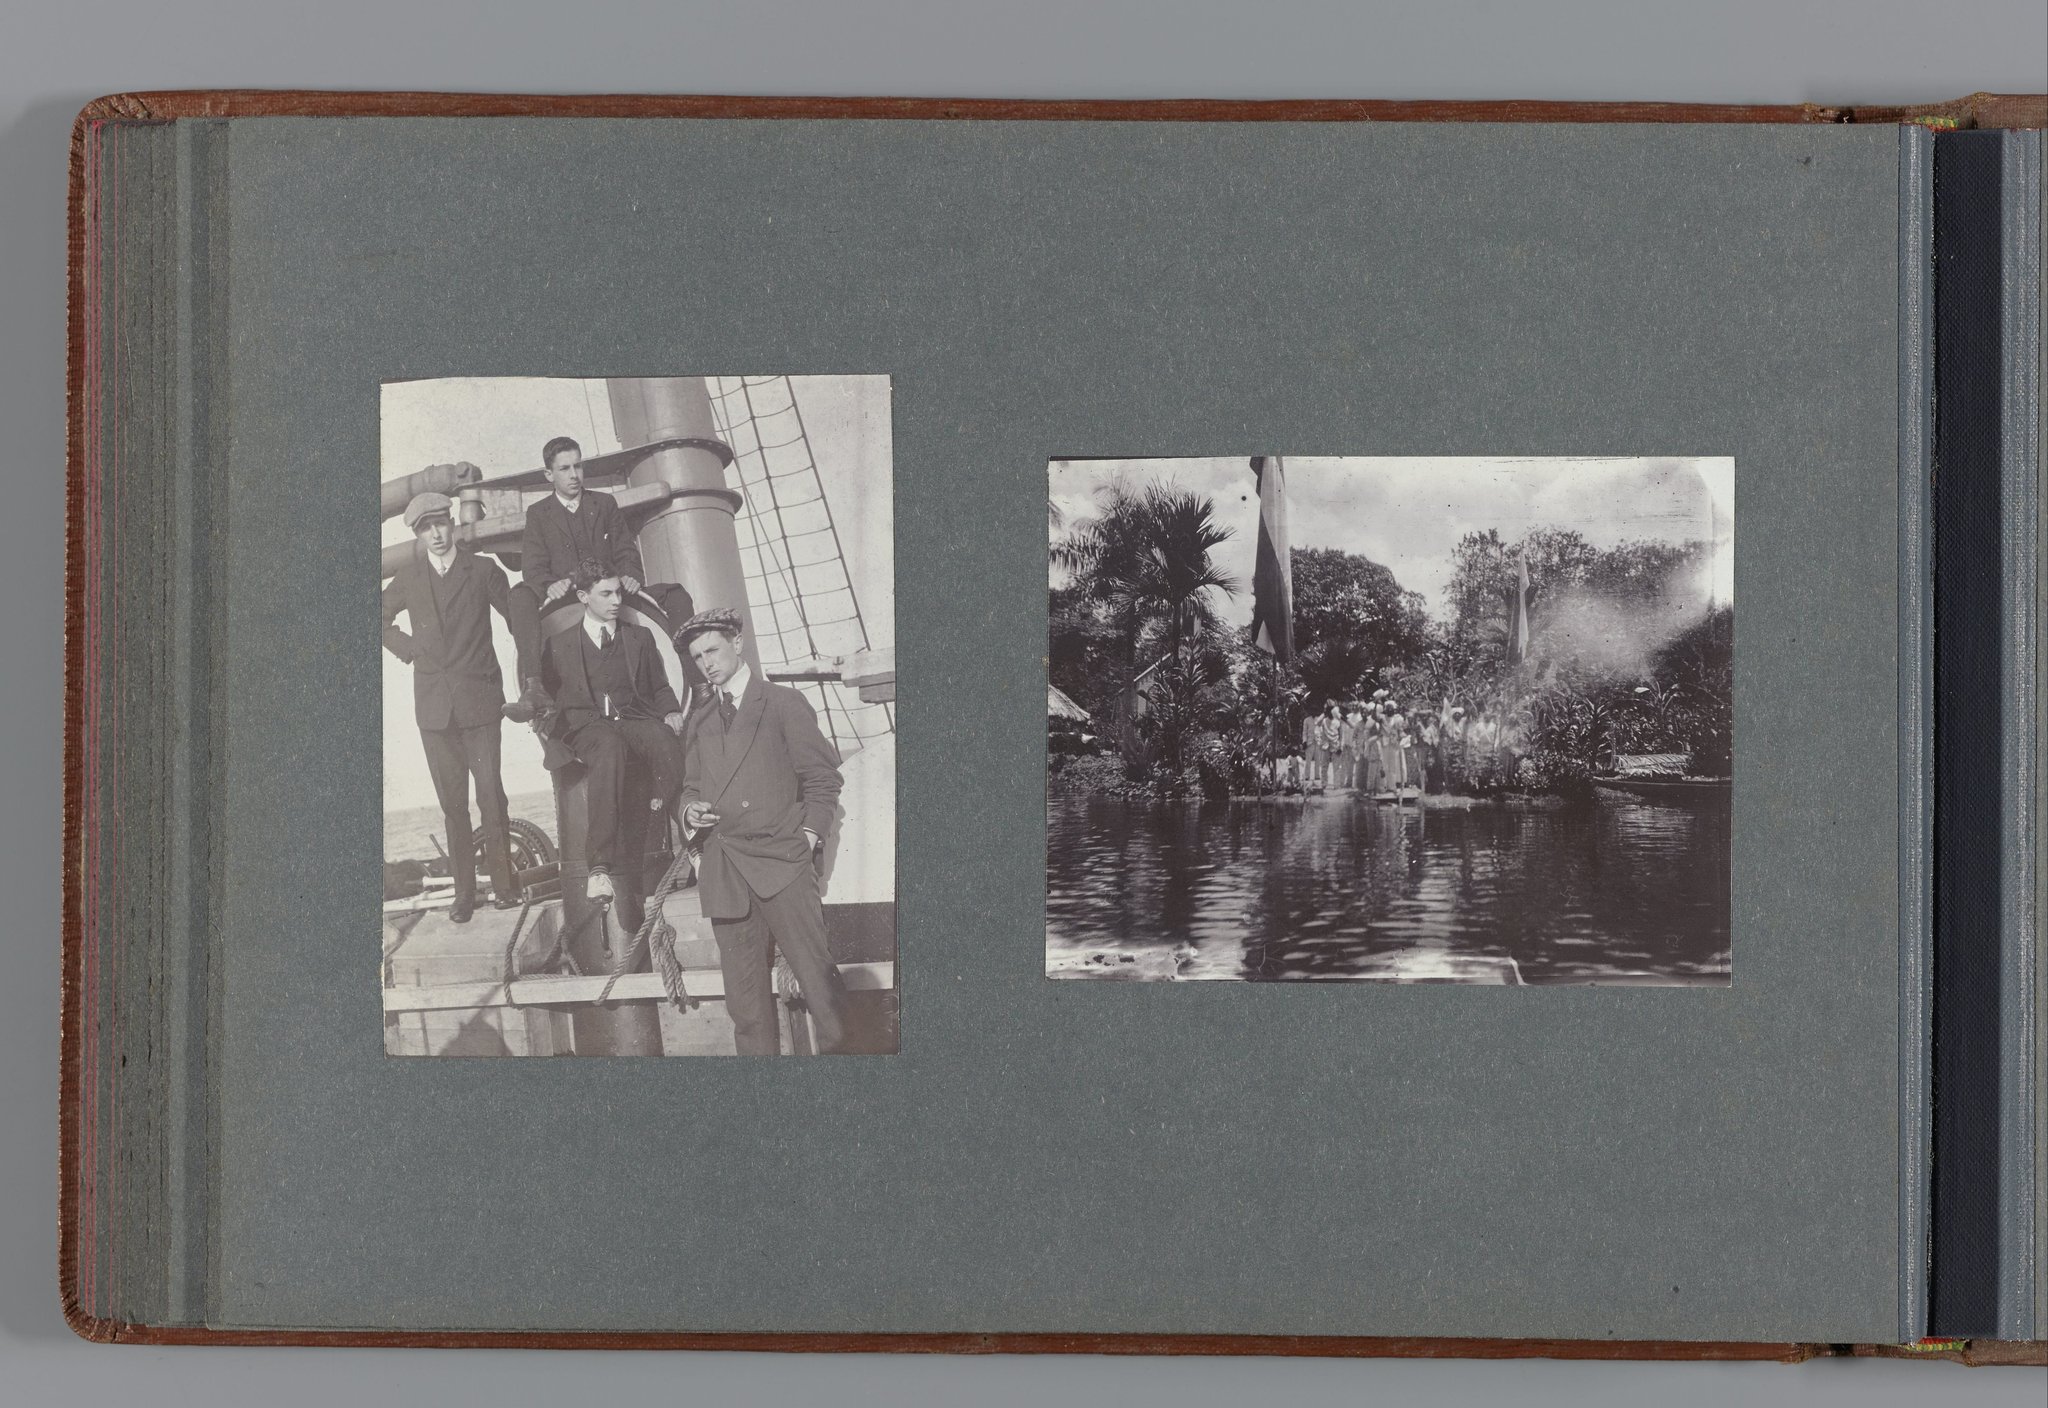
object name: photograph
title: Groep Surinamers (?) staand tussen twee vlaggen, gezien vanaf het water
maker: Anonymous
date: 1905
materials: cardboard, paper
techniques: photography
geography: paramaribo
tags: suriname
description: Groep Surinamers (?) staand tussen twee vlaggen, gezien vanaf het water. Onderdeel van fotoalbum 'Suriname'.